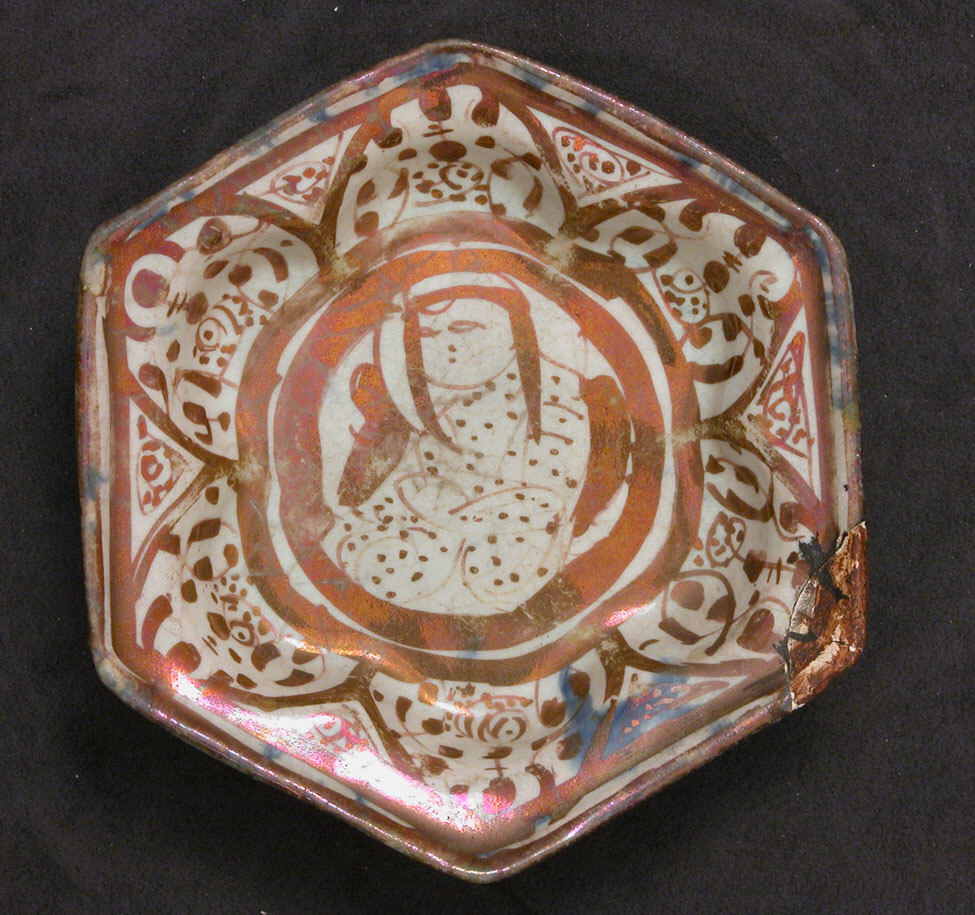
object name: dish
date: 1167-1233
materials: stonepaste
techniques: glazing, luster painting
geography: iran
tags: human figures